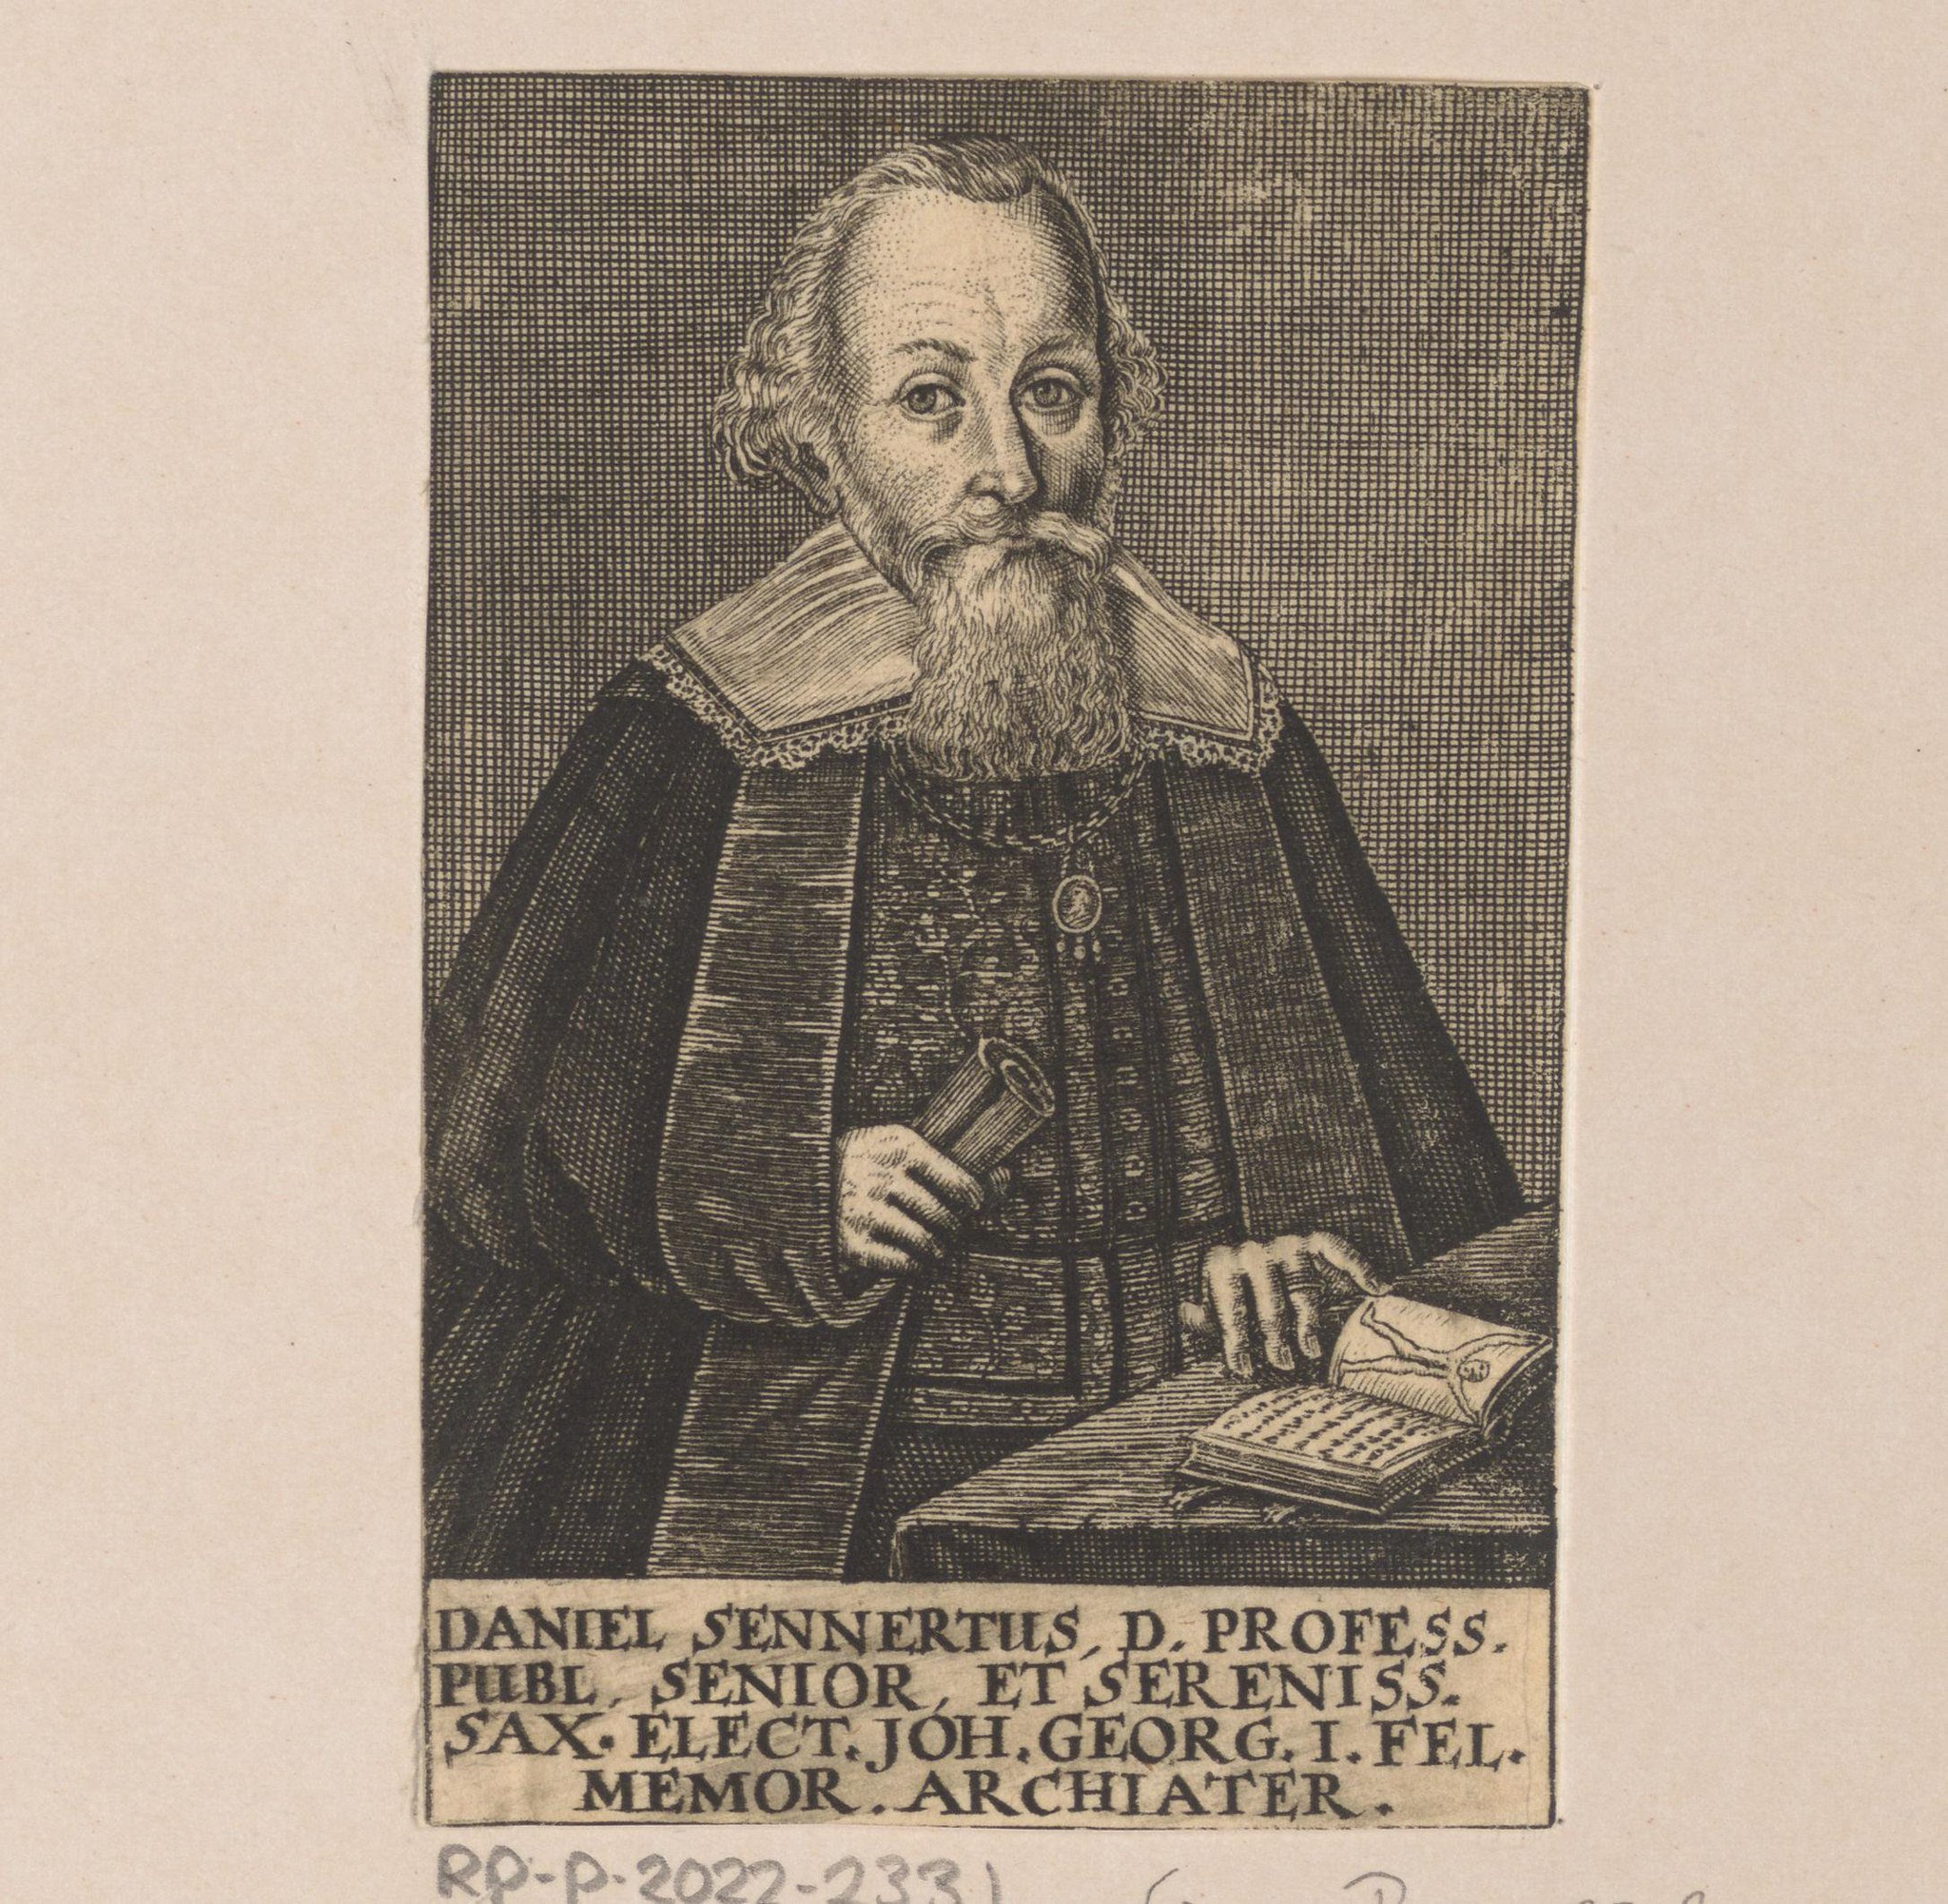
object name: print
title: Portret van Daniel Sennert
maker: johann-baptist paravicini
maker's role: print maker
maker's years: -1676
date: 1686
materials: paper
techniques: engraving, etching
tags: scholar, philosopher, historical persons, physician, doctor, professor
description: Prent waarschijnlijk uit: Sennert, Daniel. Epitome institutionum medicinae et librorum de febribus. Ed. III. ab autore adhuc recensita et aucta. Frankfurt/Leipzig: Balthasar Christoph Wust, 1686.